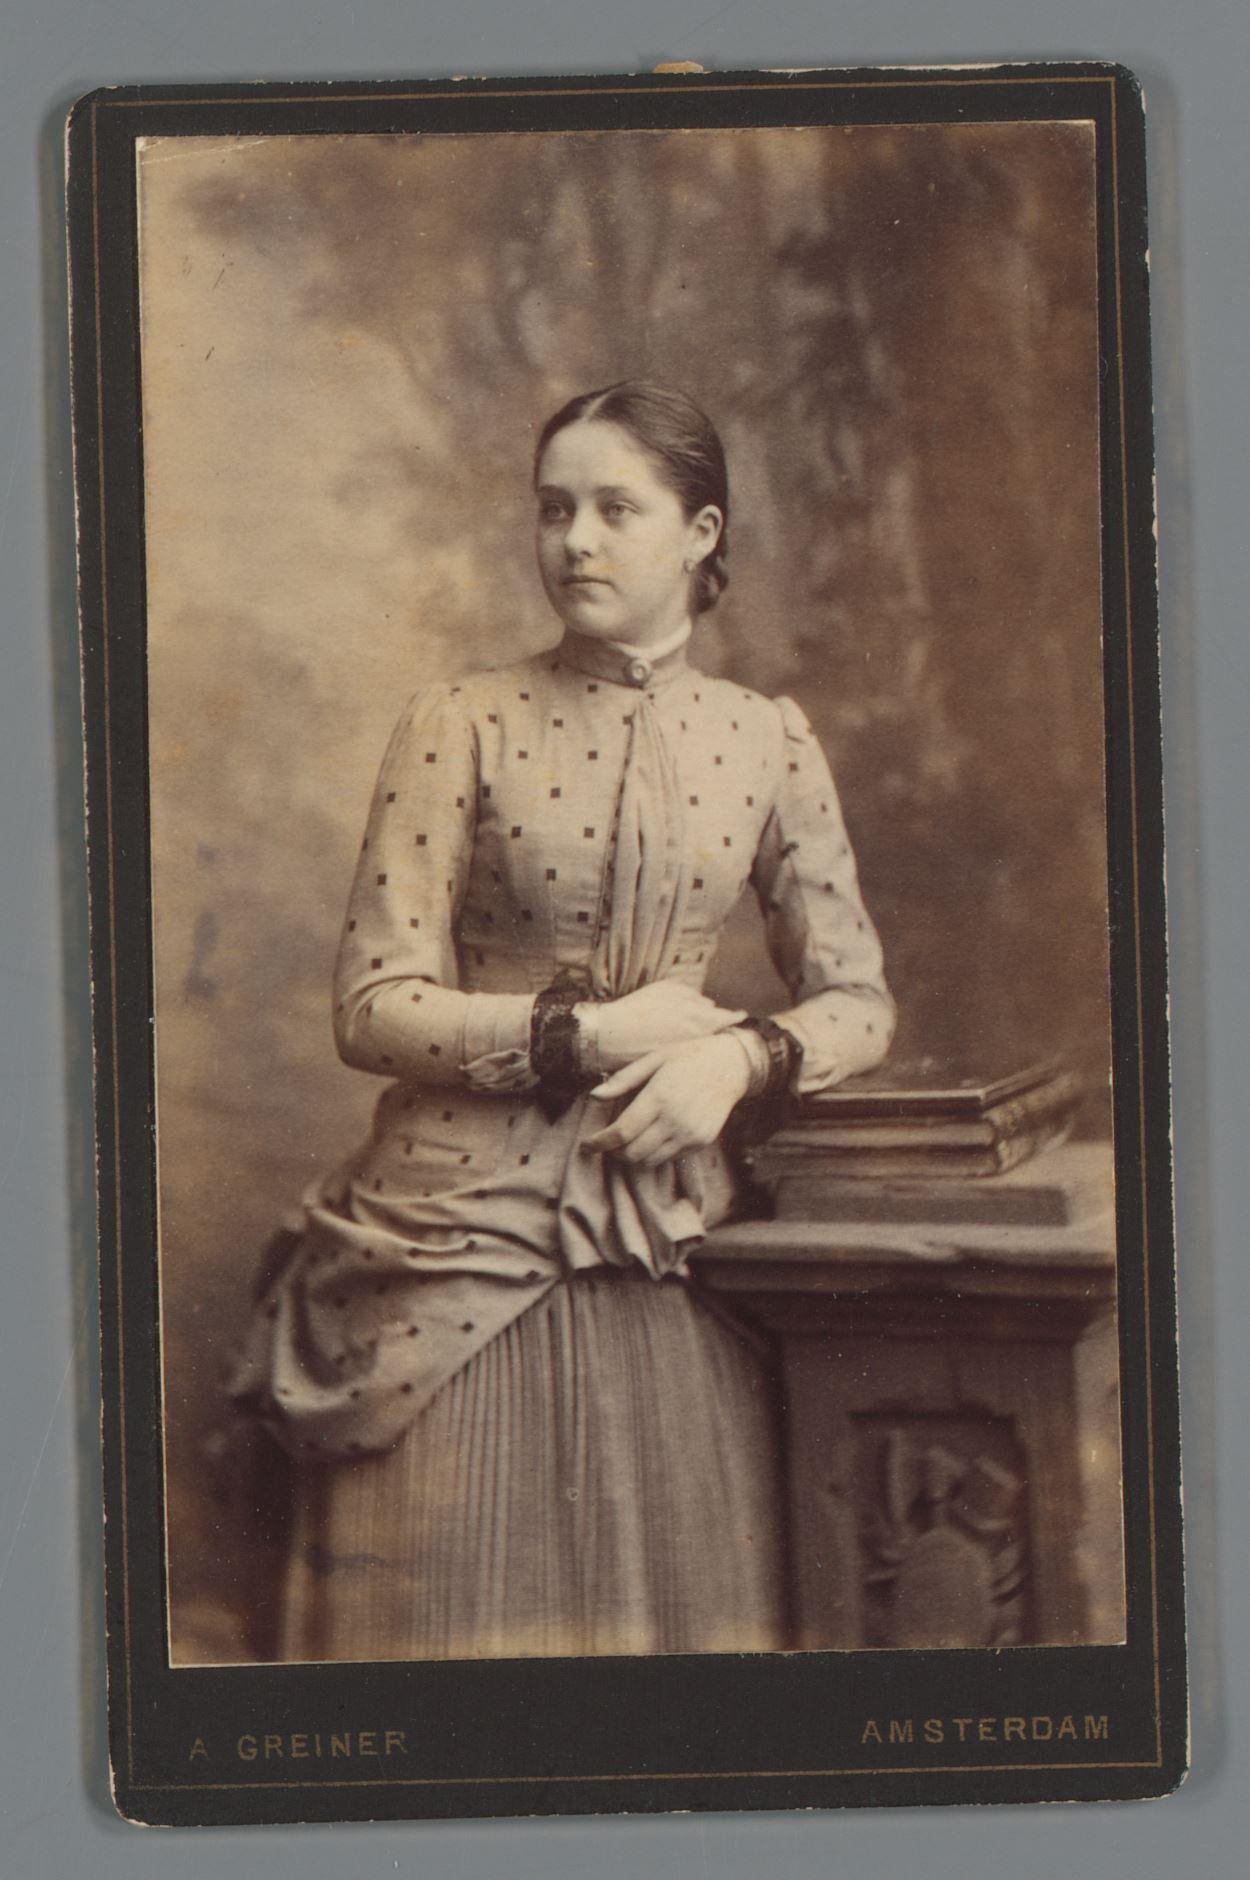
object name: carte de visite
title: Portret van Anne Gesiena Jonker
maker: albert greiner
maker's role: fotograaf, fotostudio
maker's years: 1833-1890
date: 1870-1887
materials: cardboard, photographic support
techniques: collodion silver print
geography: amsterdam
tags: historical persons, amsterdam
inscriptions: name: ‘A.G. Jonker’, workshop stamp: ‘A. Greiner/ Photograph/ Nieuwendyk L. 89, Amsterdam’